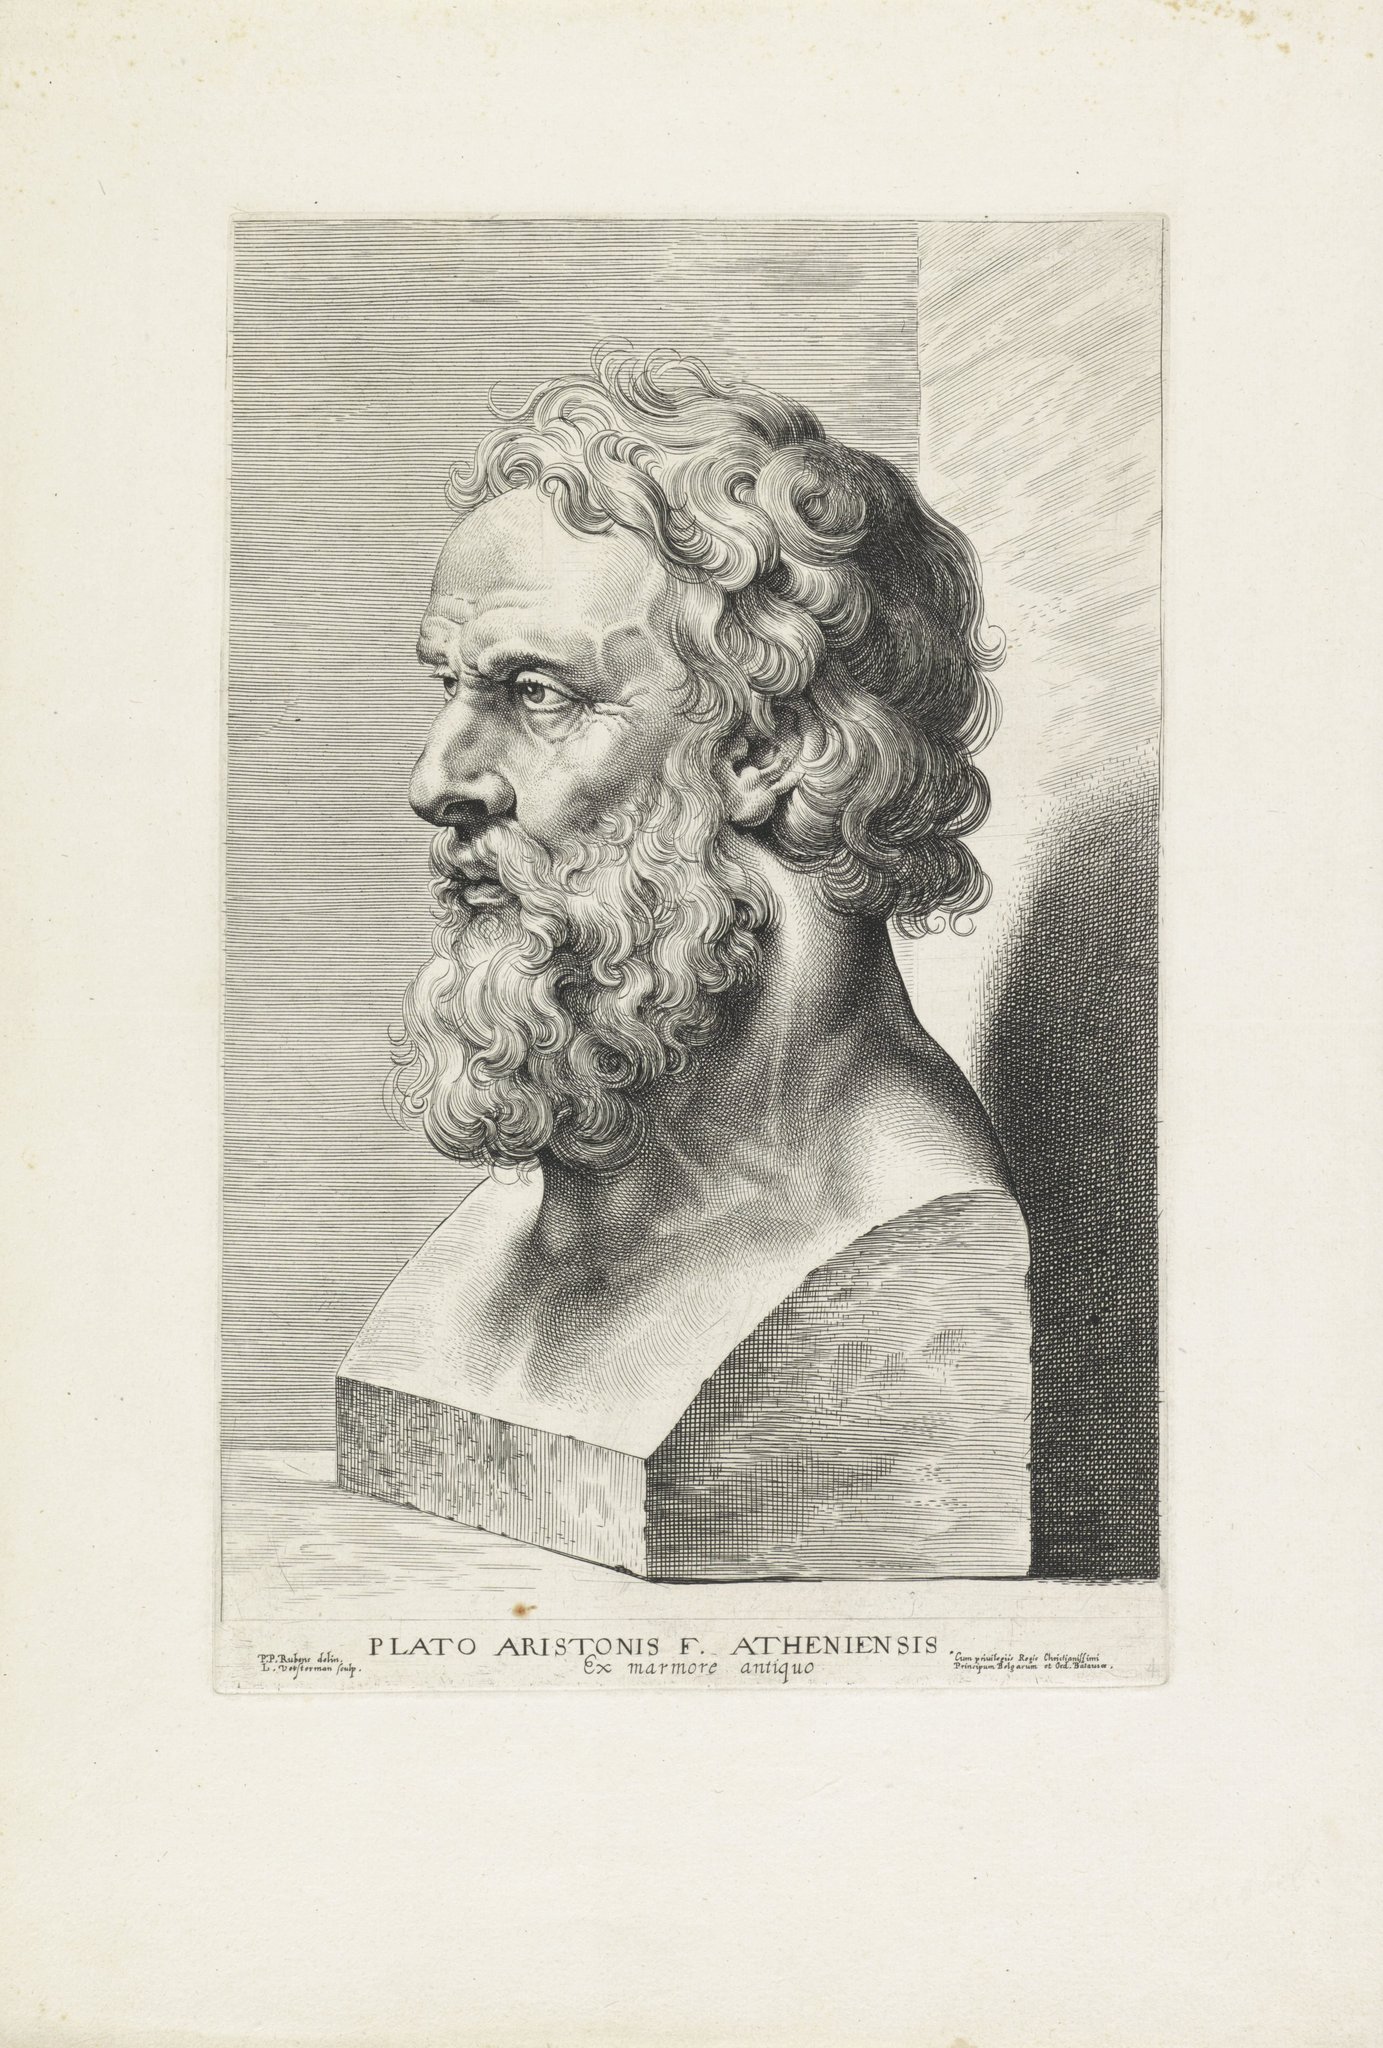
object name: print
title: Buste van Plato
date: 1630-1638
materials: paper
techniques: engraving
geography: antwerp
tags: male persons from classical history (plato), piece of sculpture, reproduction of a piece of sculpture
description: Buste van Plato. Prent uit een serie van twaalf prenten met antieke bustes, waarvan vier door Lucas Vorsterman I en acht door Boëtius Adamsz. Bolswert.